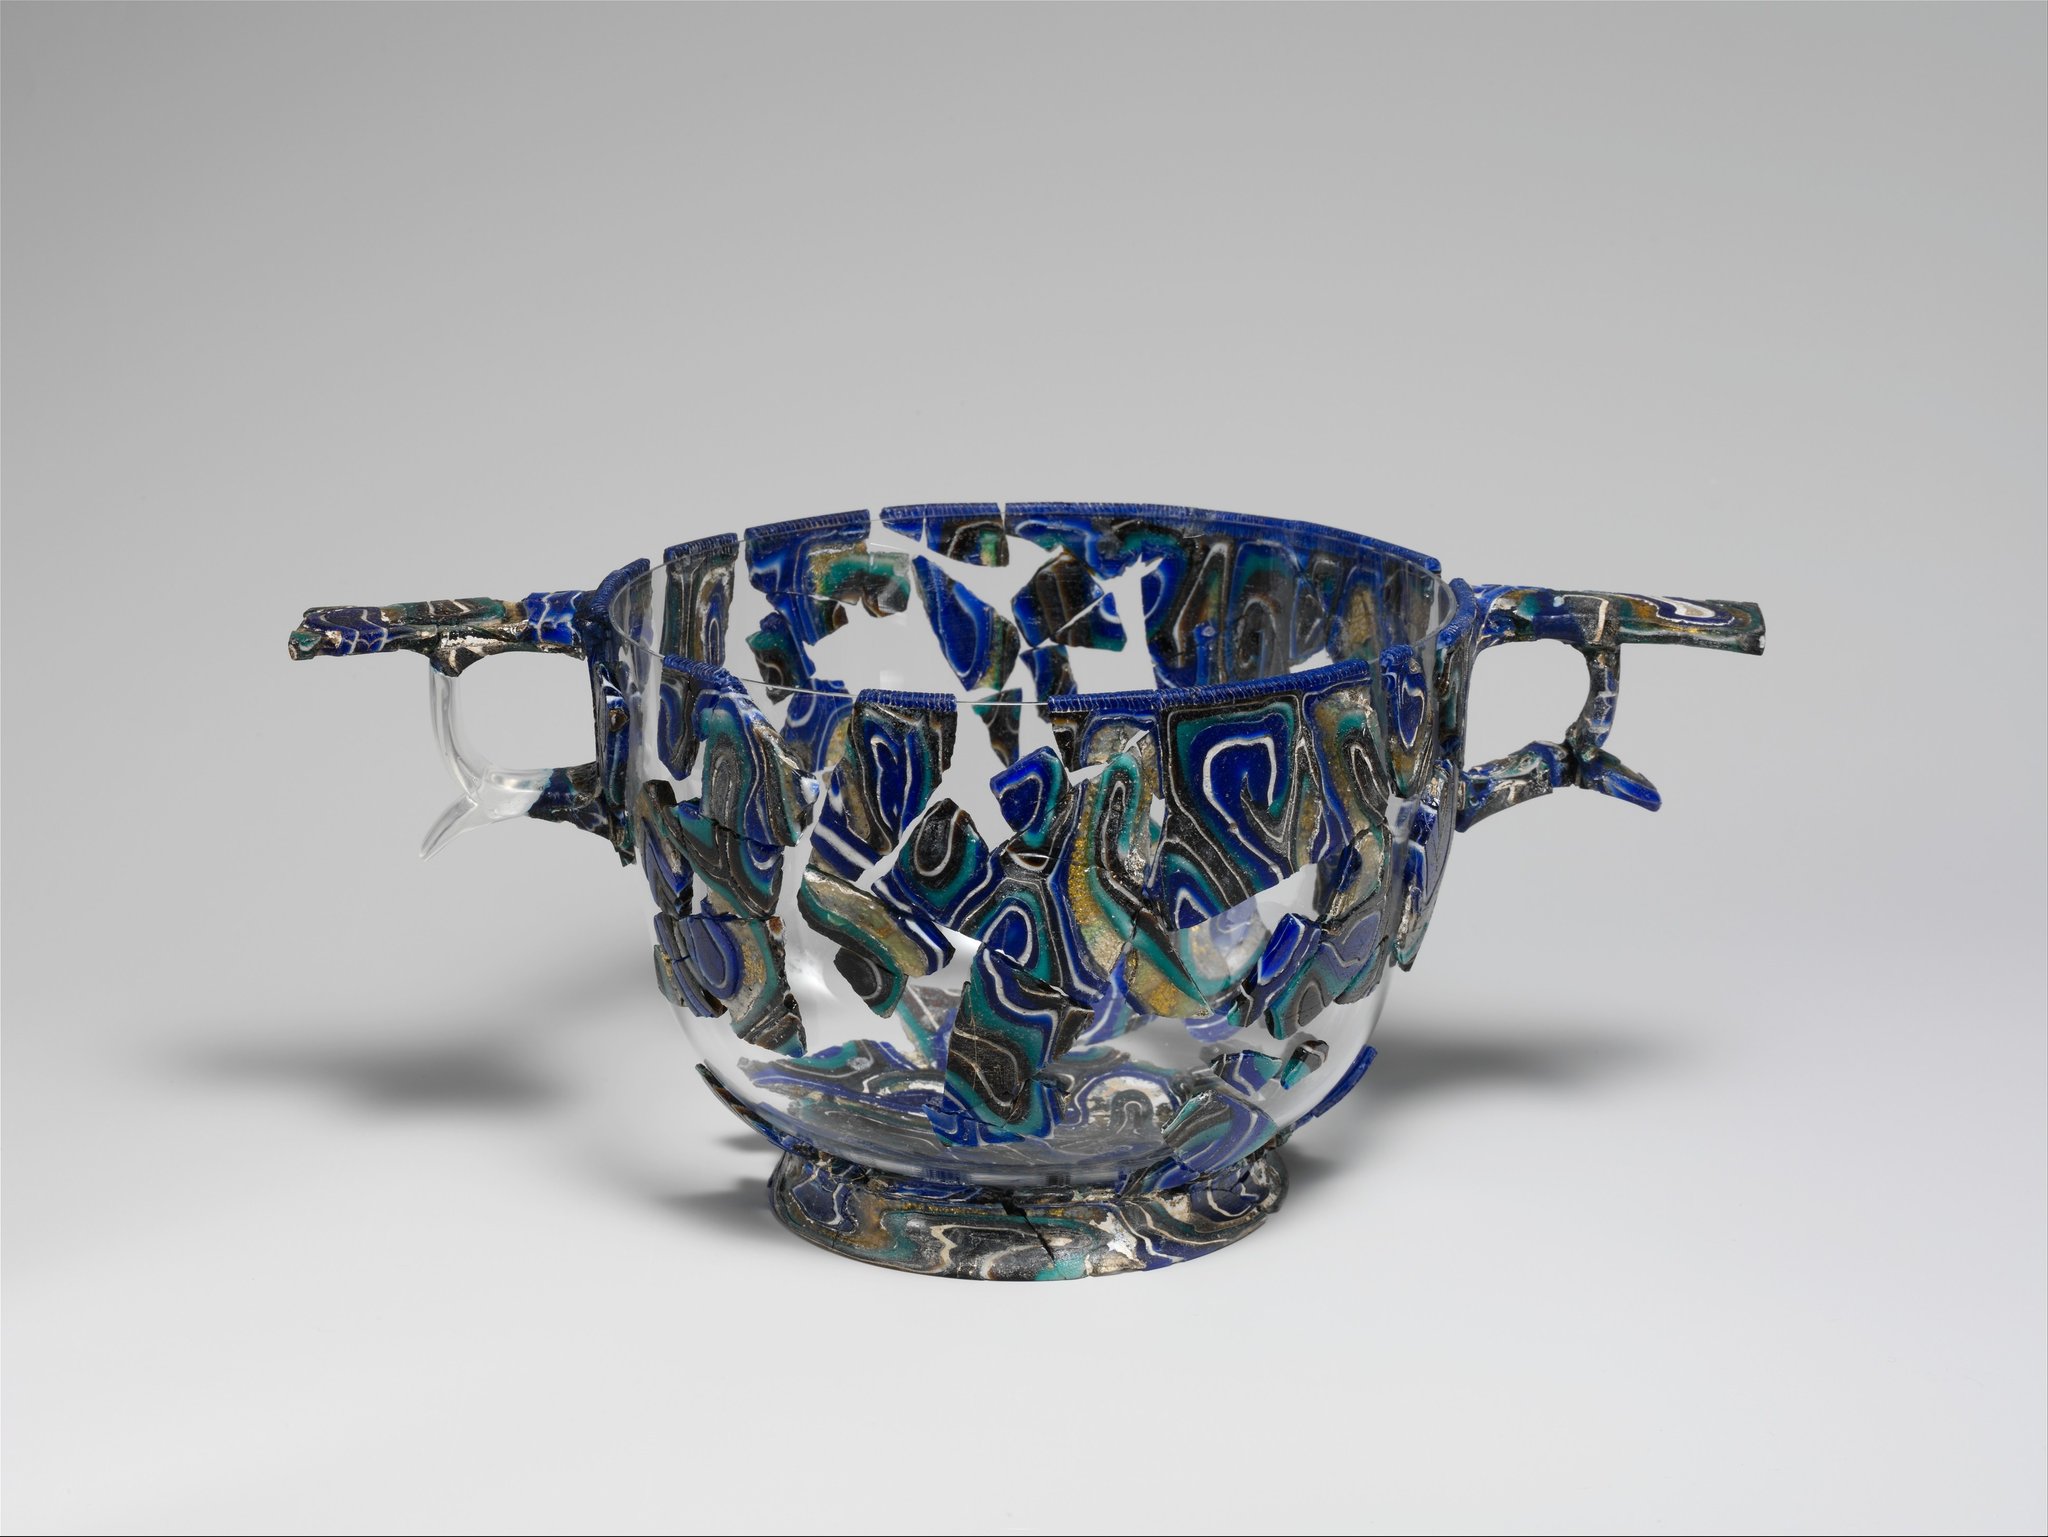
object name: skyphos, gold band mosaic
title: Glass gold-band mosaic scyphus (drinking cup)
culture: roman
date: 34 BCE-33 CE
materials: glass